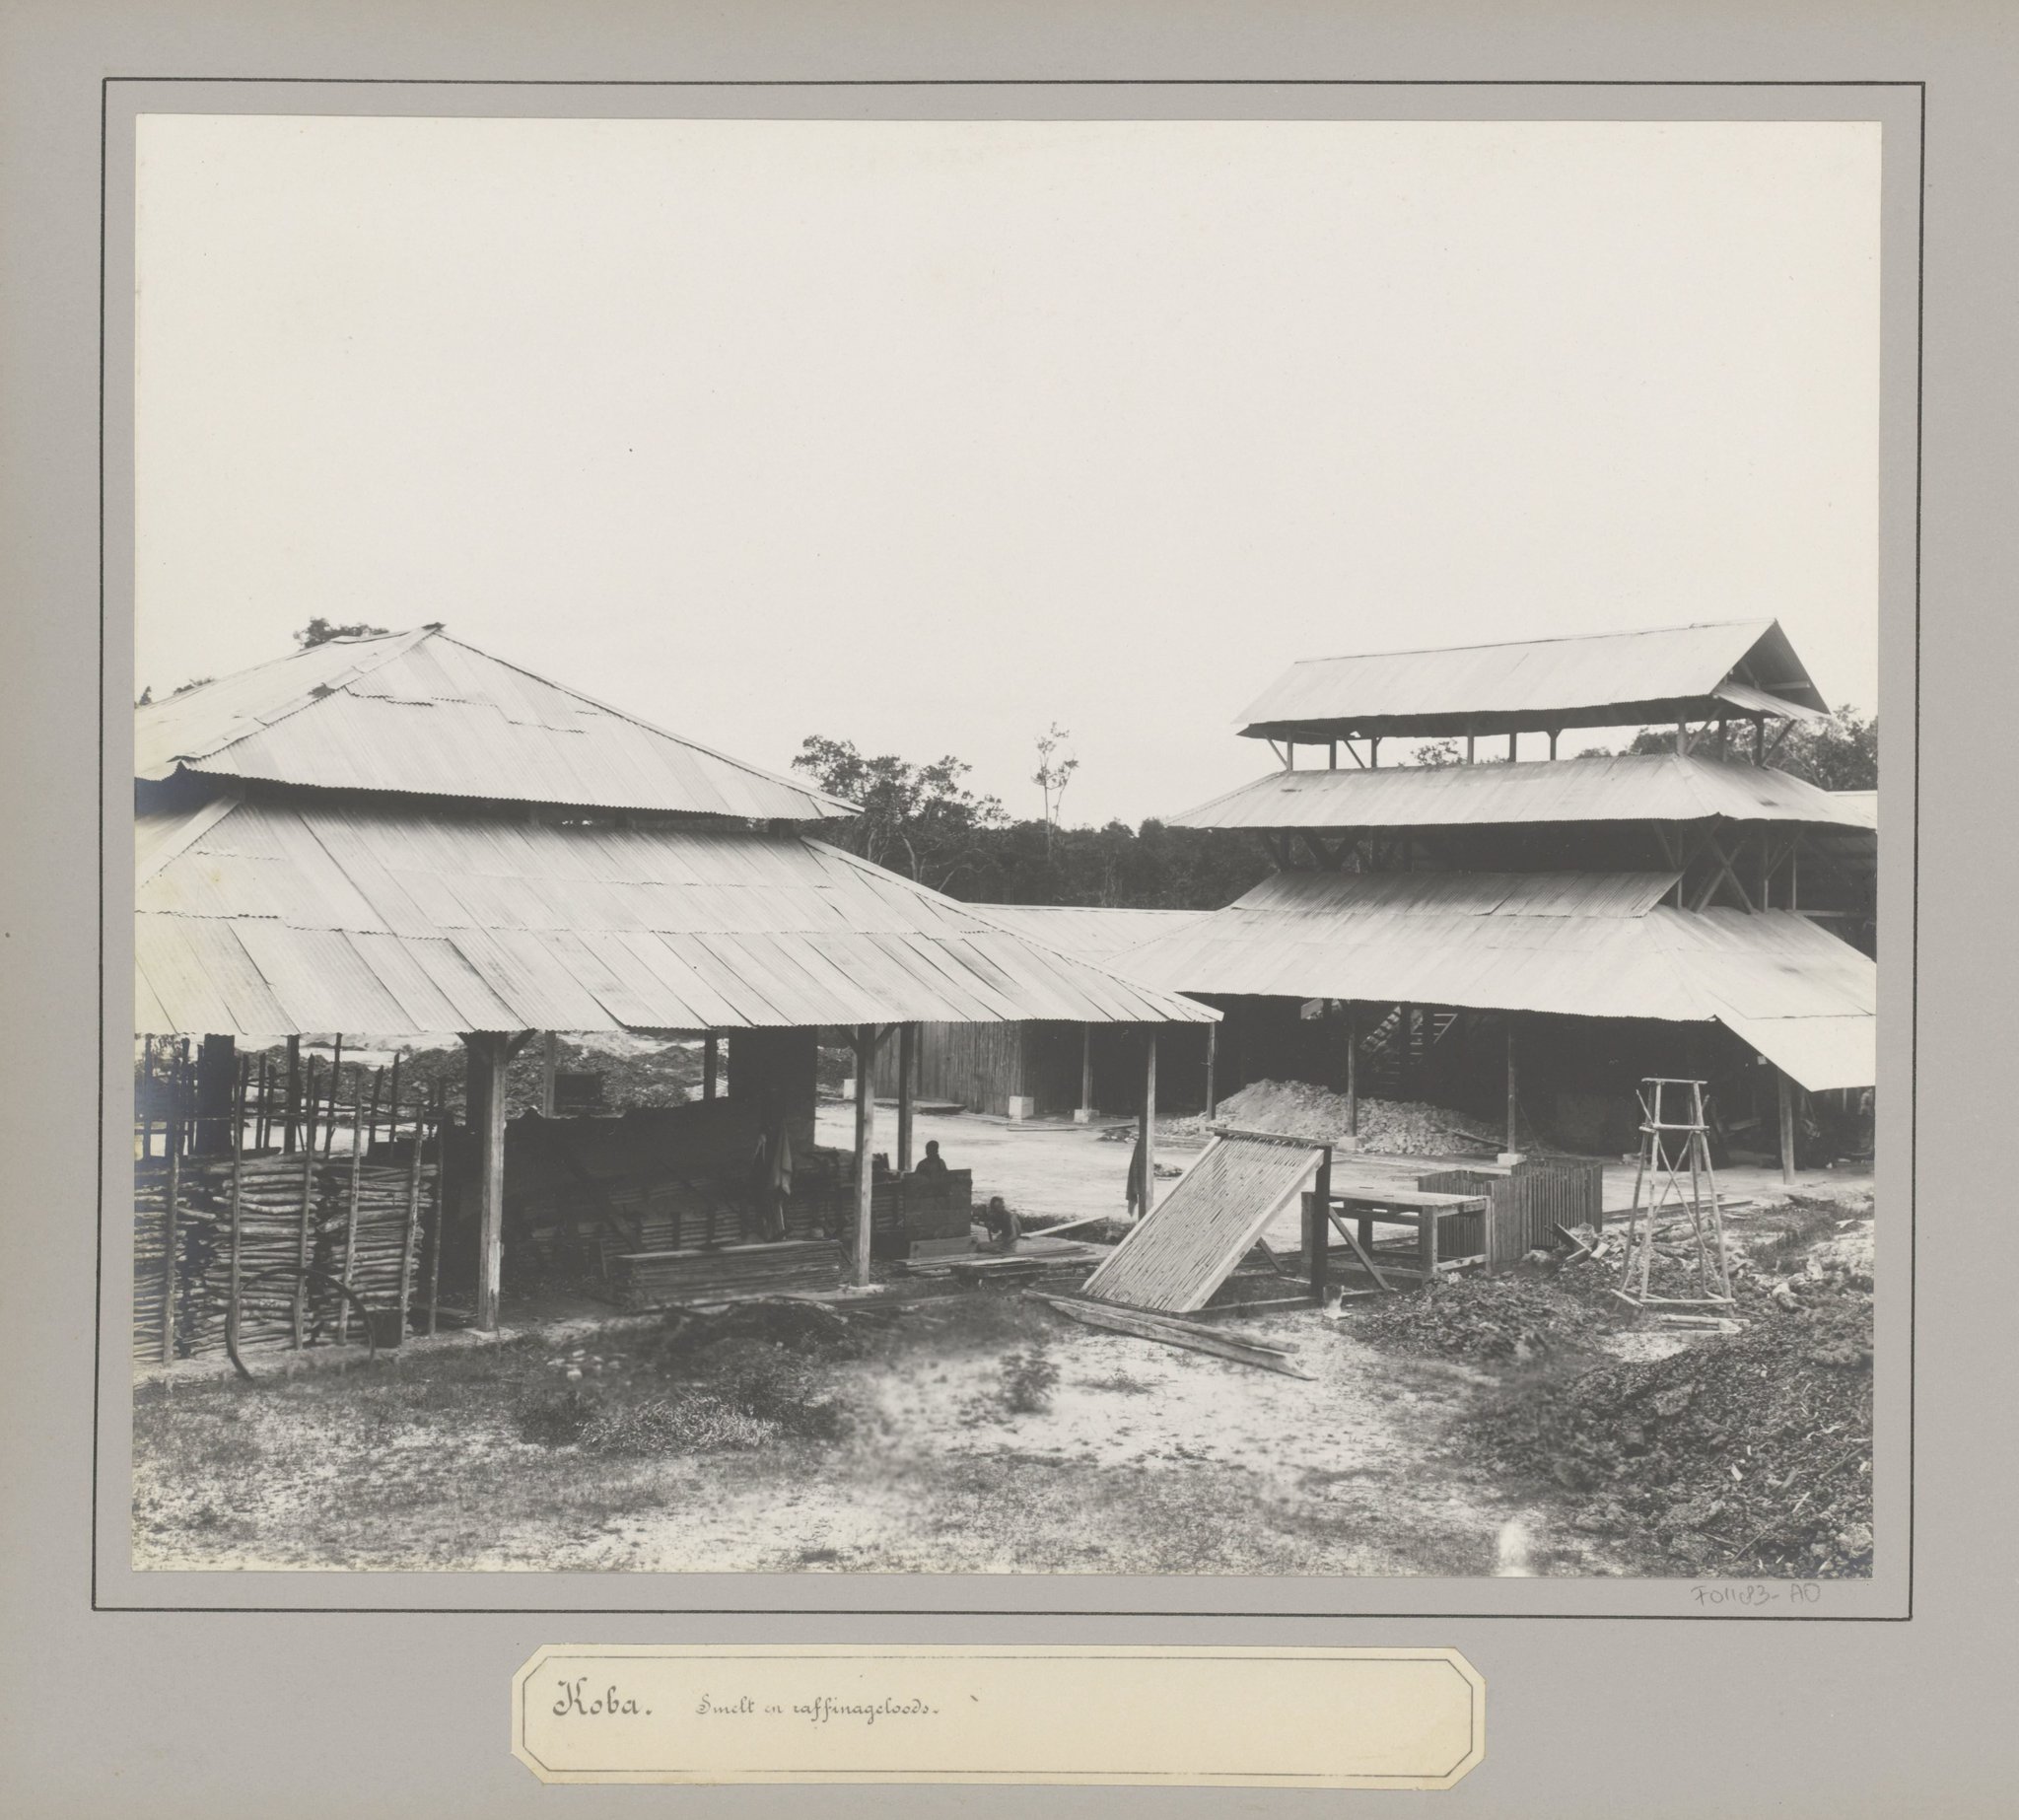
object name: photograph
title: Loodsen van een tinonderneming te Koba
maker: Anonymous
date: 1900-1920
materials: photographic support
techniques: gelatin silver print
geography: koba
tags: large-scale structure for storage, e.g.: warehouse, depot, silo, mining, minerals and metals: tin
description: Onderdeel van Fotoalbum over de tinwinning op Bangka.